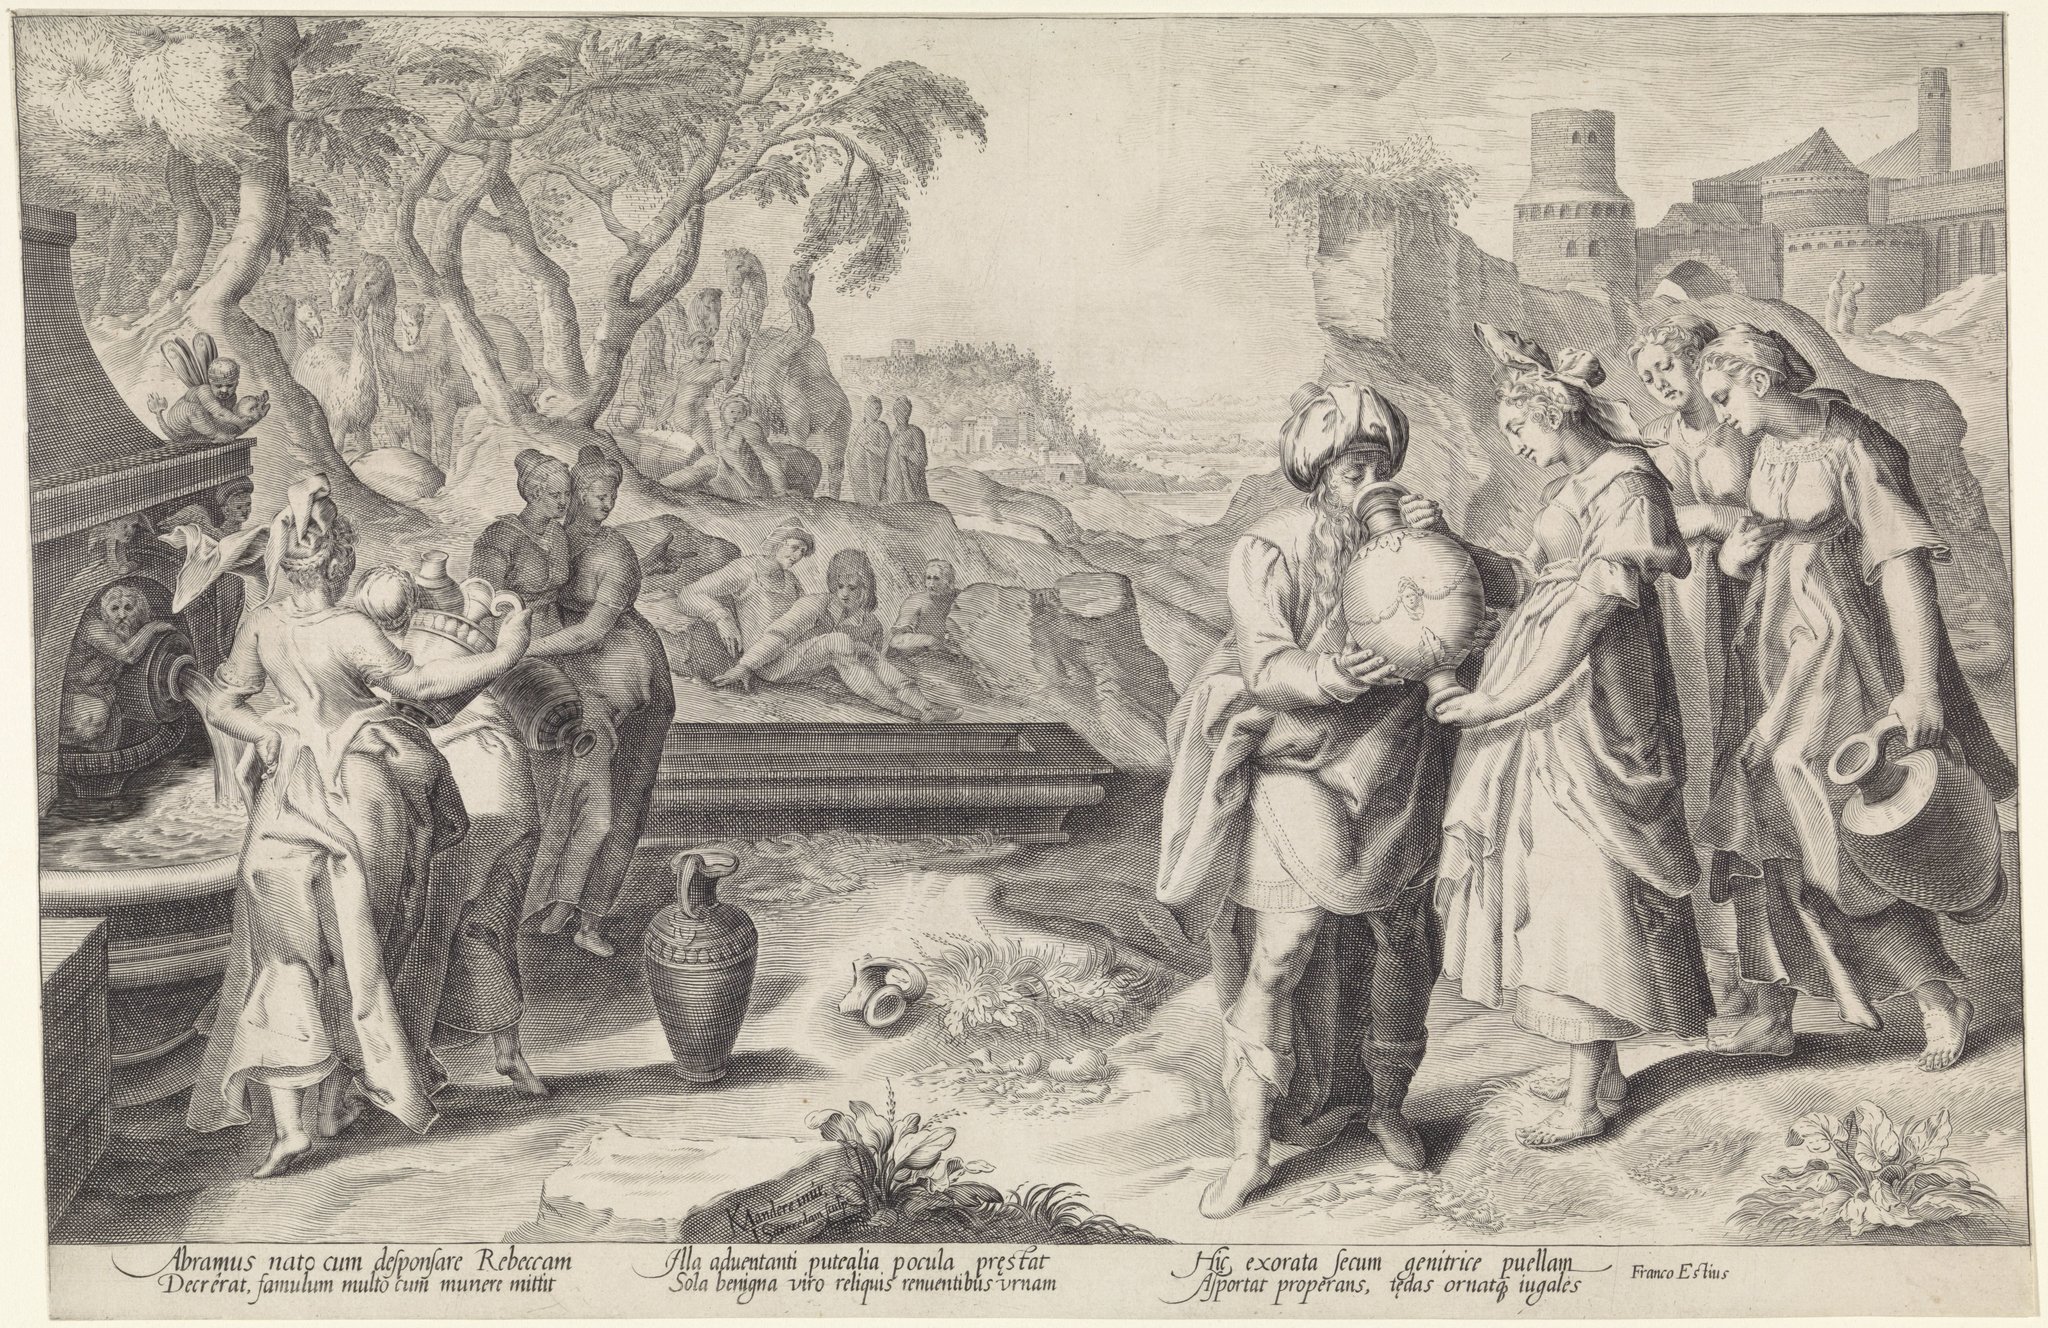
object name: print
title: Rebekka en Eliëzer bij de bron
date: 1589-1607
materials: paper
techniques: engraving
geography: northern netherlands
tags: rebekah offers eliezer a drink from her pitcher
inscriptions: collector's mark: Lugt 240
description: Rebekka laat Eliëzer uit haar kruik drinken. Achter haar staan twee vrouwen. Links halen nog enkele vrouwen met kruiken water uit de bron. Linksachter kamelen en rustende reizigers tussen de bomen. Rechtsachter een burcht op een rots. Onder de voorstelling een zesregelige, Latijnse tekst met een toelichting op de scène.